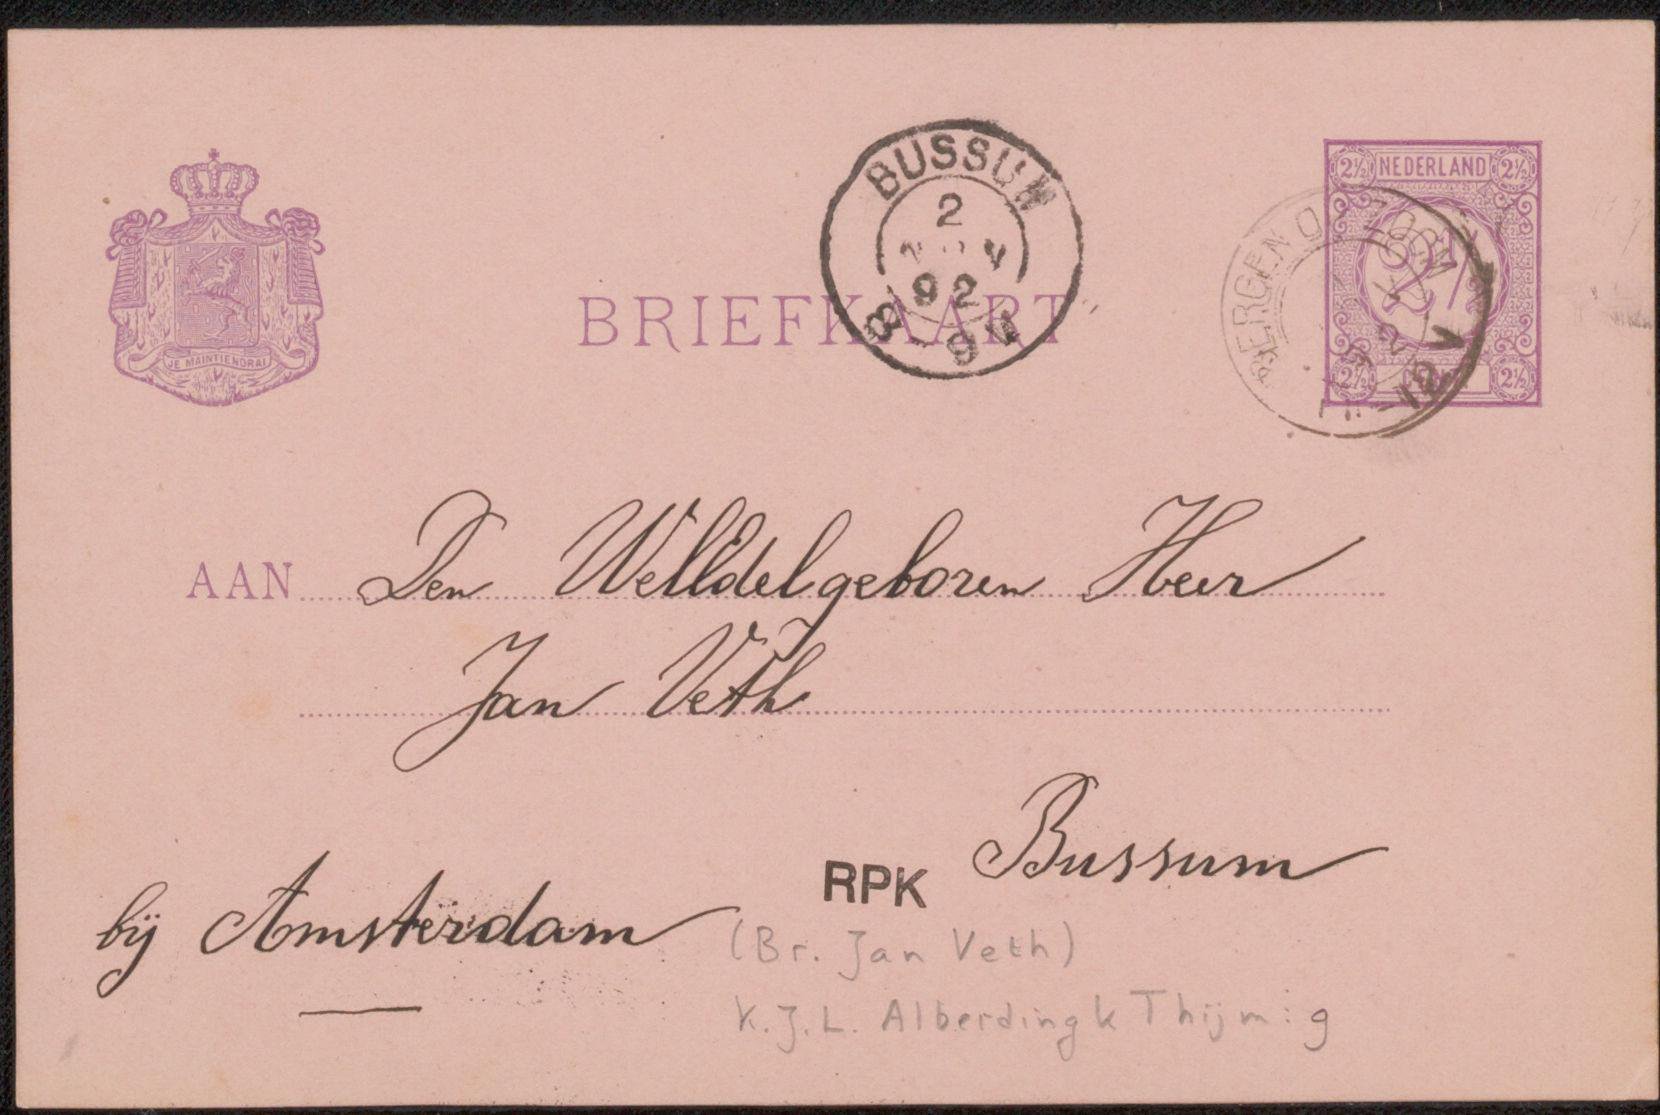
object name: postcard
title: Briefkaart aan Jan Veth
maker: Anonymous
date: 1892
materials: cardboard, ink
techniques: pen, writing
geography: bergen op zoom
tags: dordrecht, amsterdam, painter, print maker, draughtsman, designer, jan veth, diseases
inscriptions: collector's mark: ‘RPK’